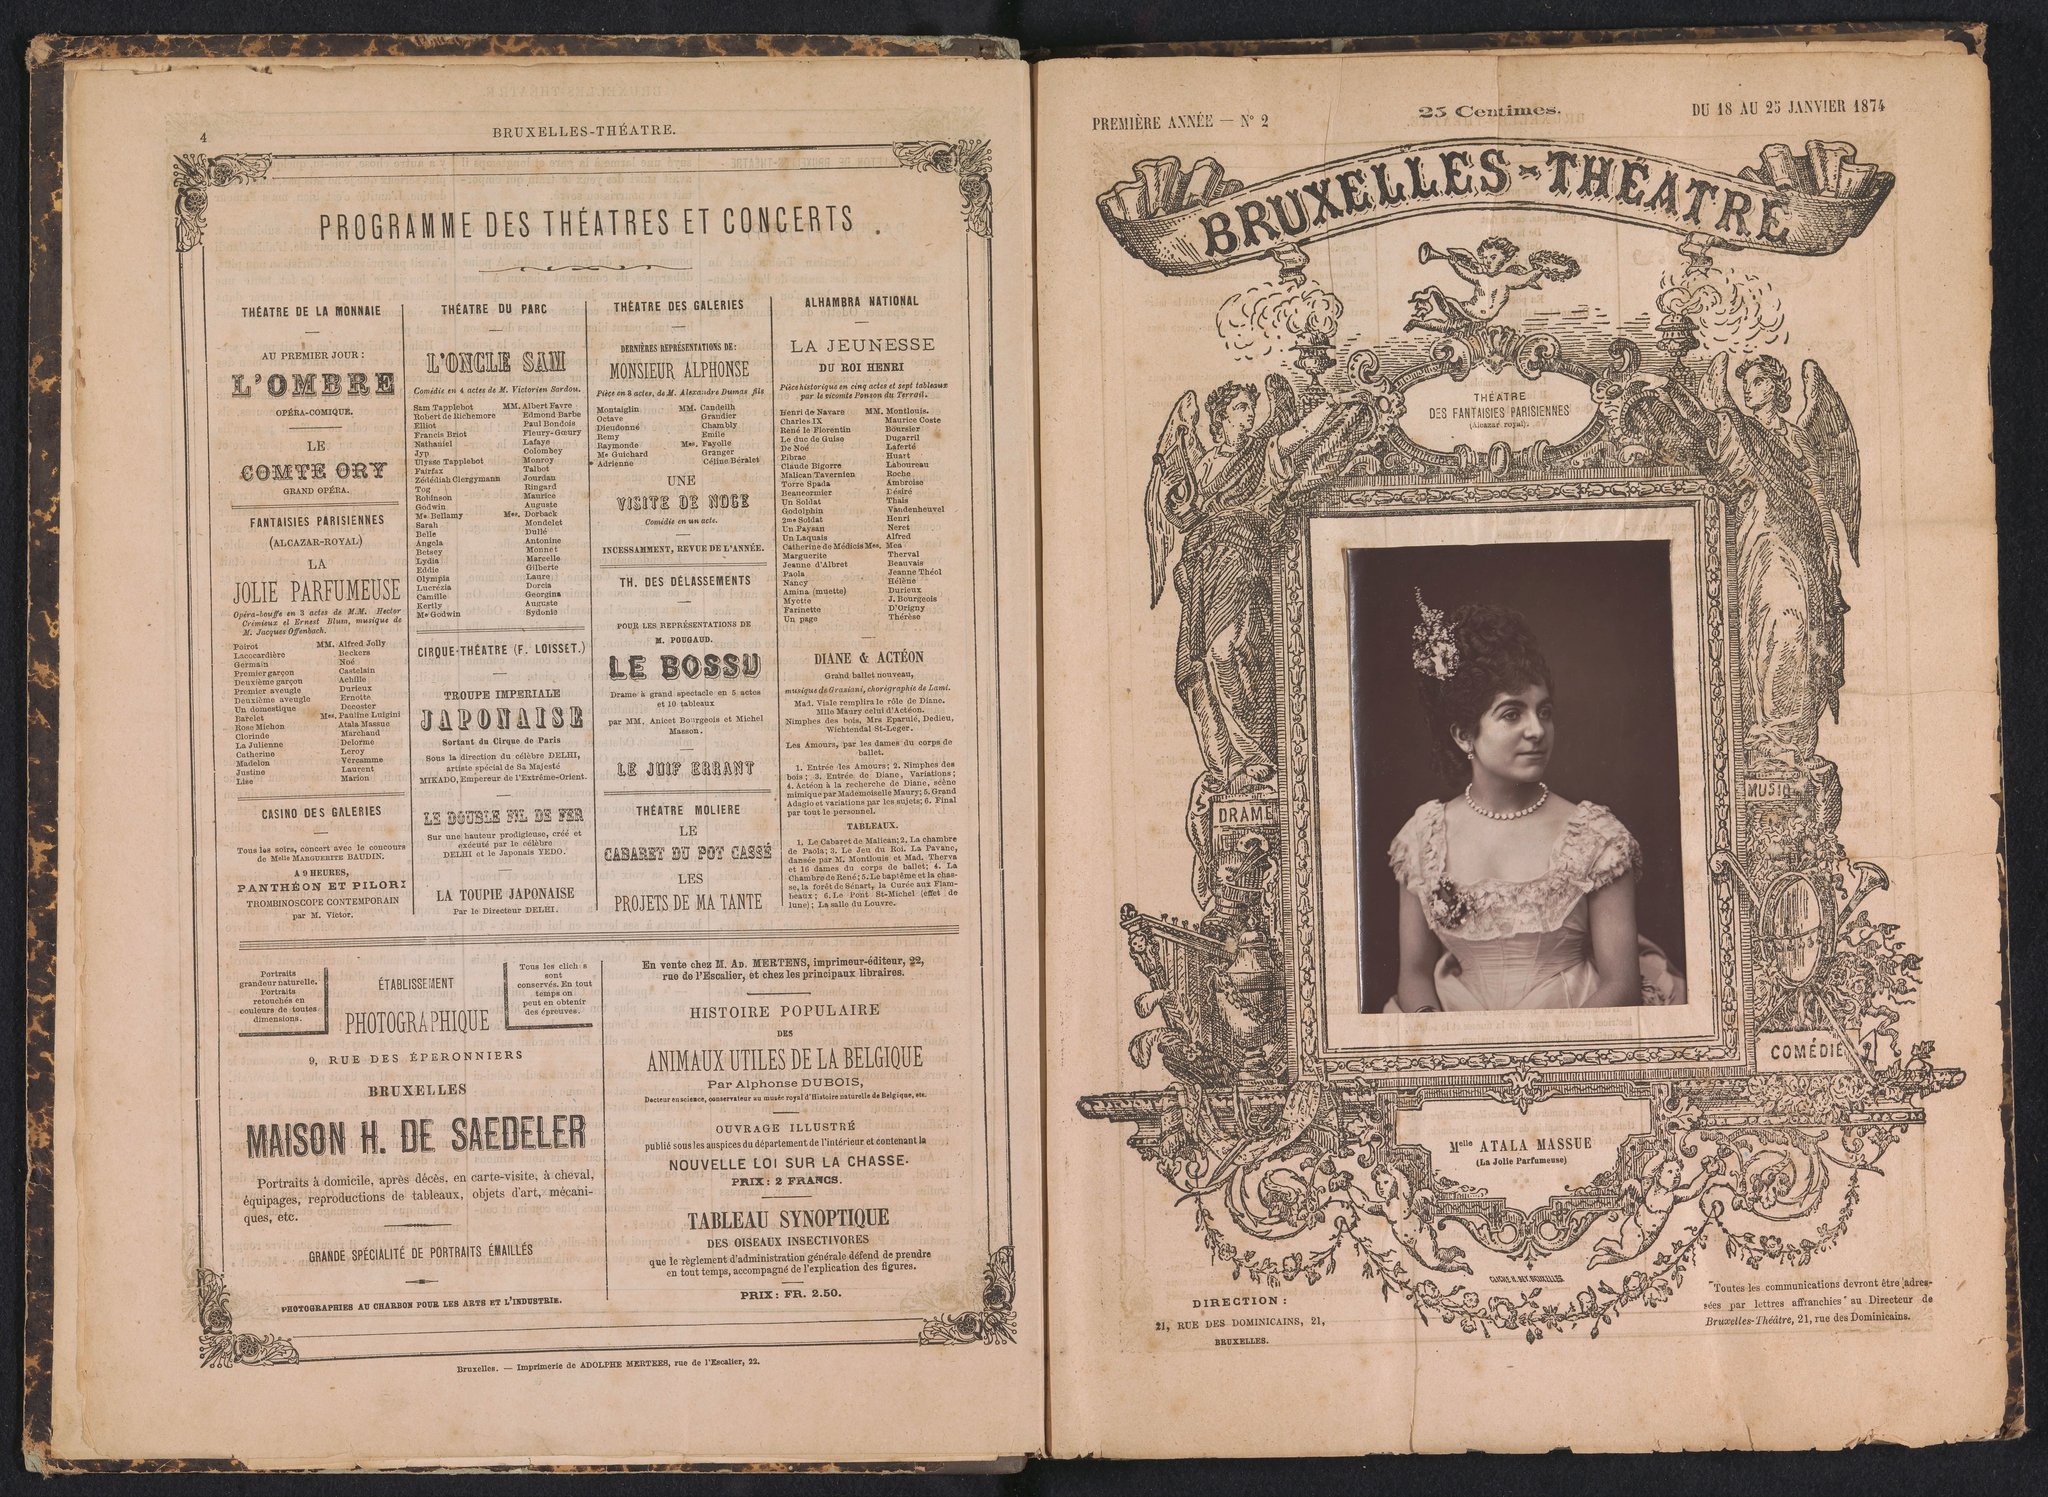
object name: page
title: Melle Atala Massue (La jolie parfumeuse)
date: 1869-1874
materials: paper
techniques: woodburytype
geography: brussels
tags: portrait of opera-singer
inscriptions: number: ‘No 2’